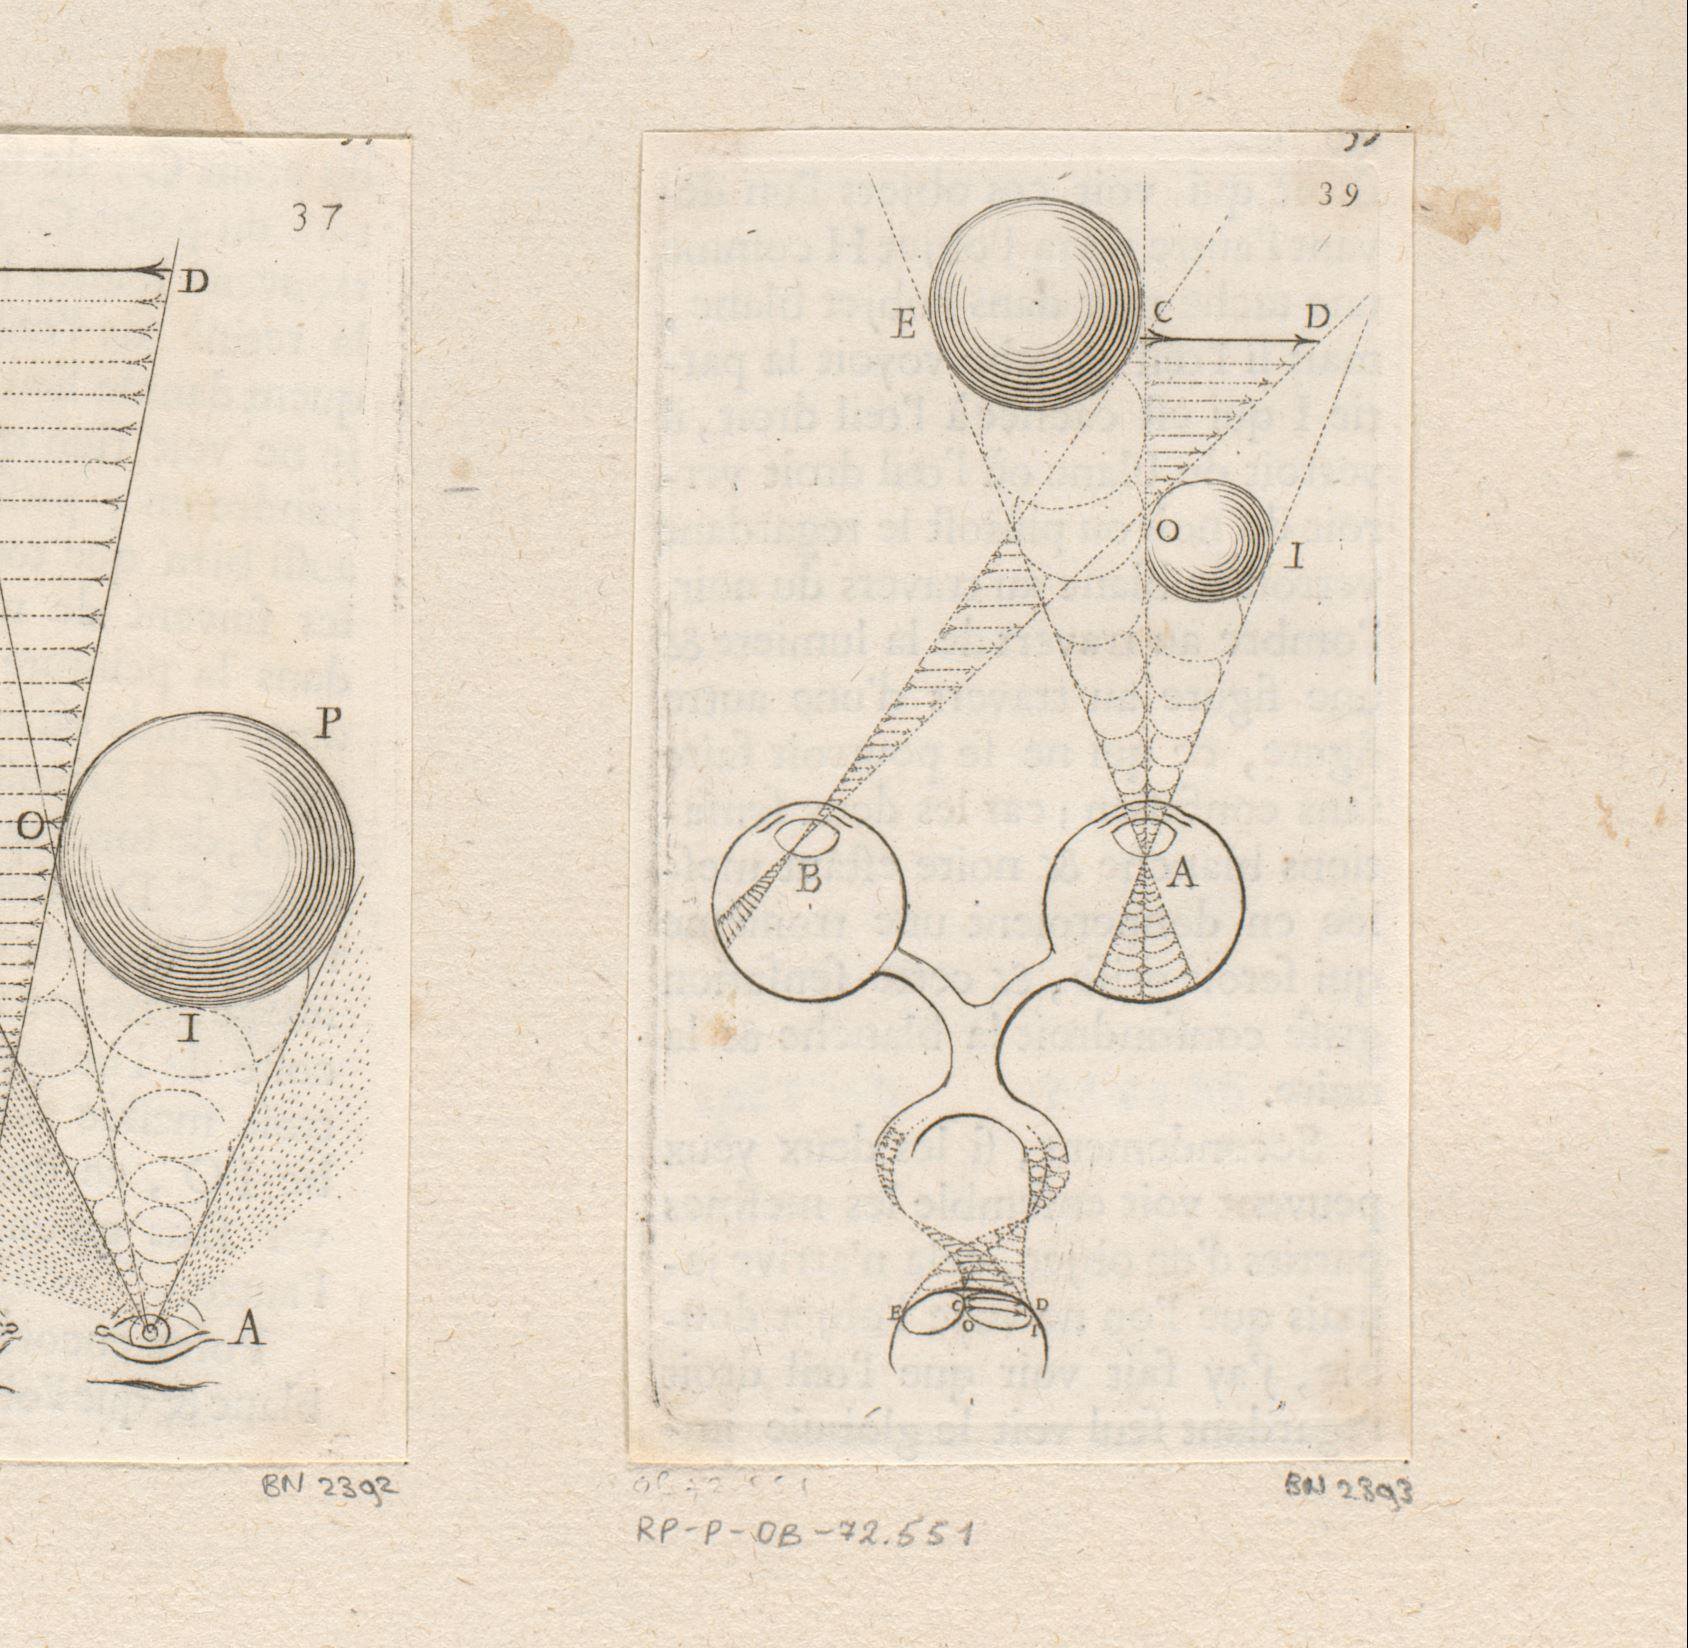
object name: print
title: Twee oogbollen met optische zenuw kijken naar twee bollen en een pijl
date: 1679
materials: paper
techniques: etching, letterpress printing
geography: paris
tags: optics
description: Prent uit: Leclerc, Sébastien. Discours touchant le point de veue, dans lequel il est prouvé que les choses qu'on voit (...). Parijs: Thomas Jolly, 1679.